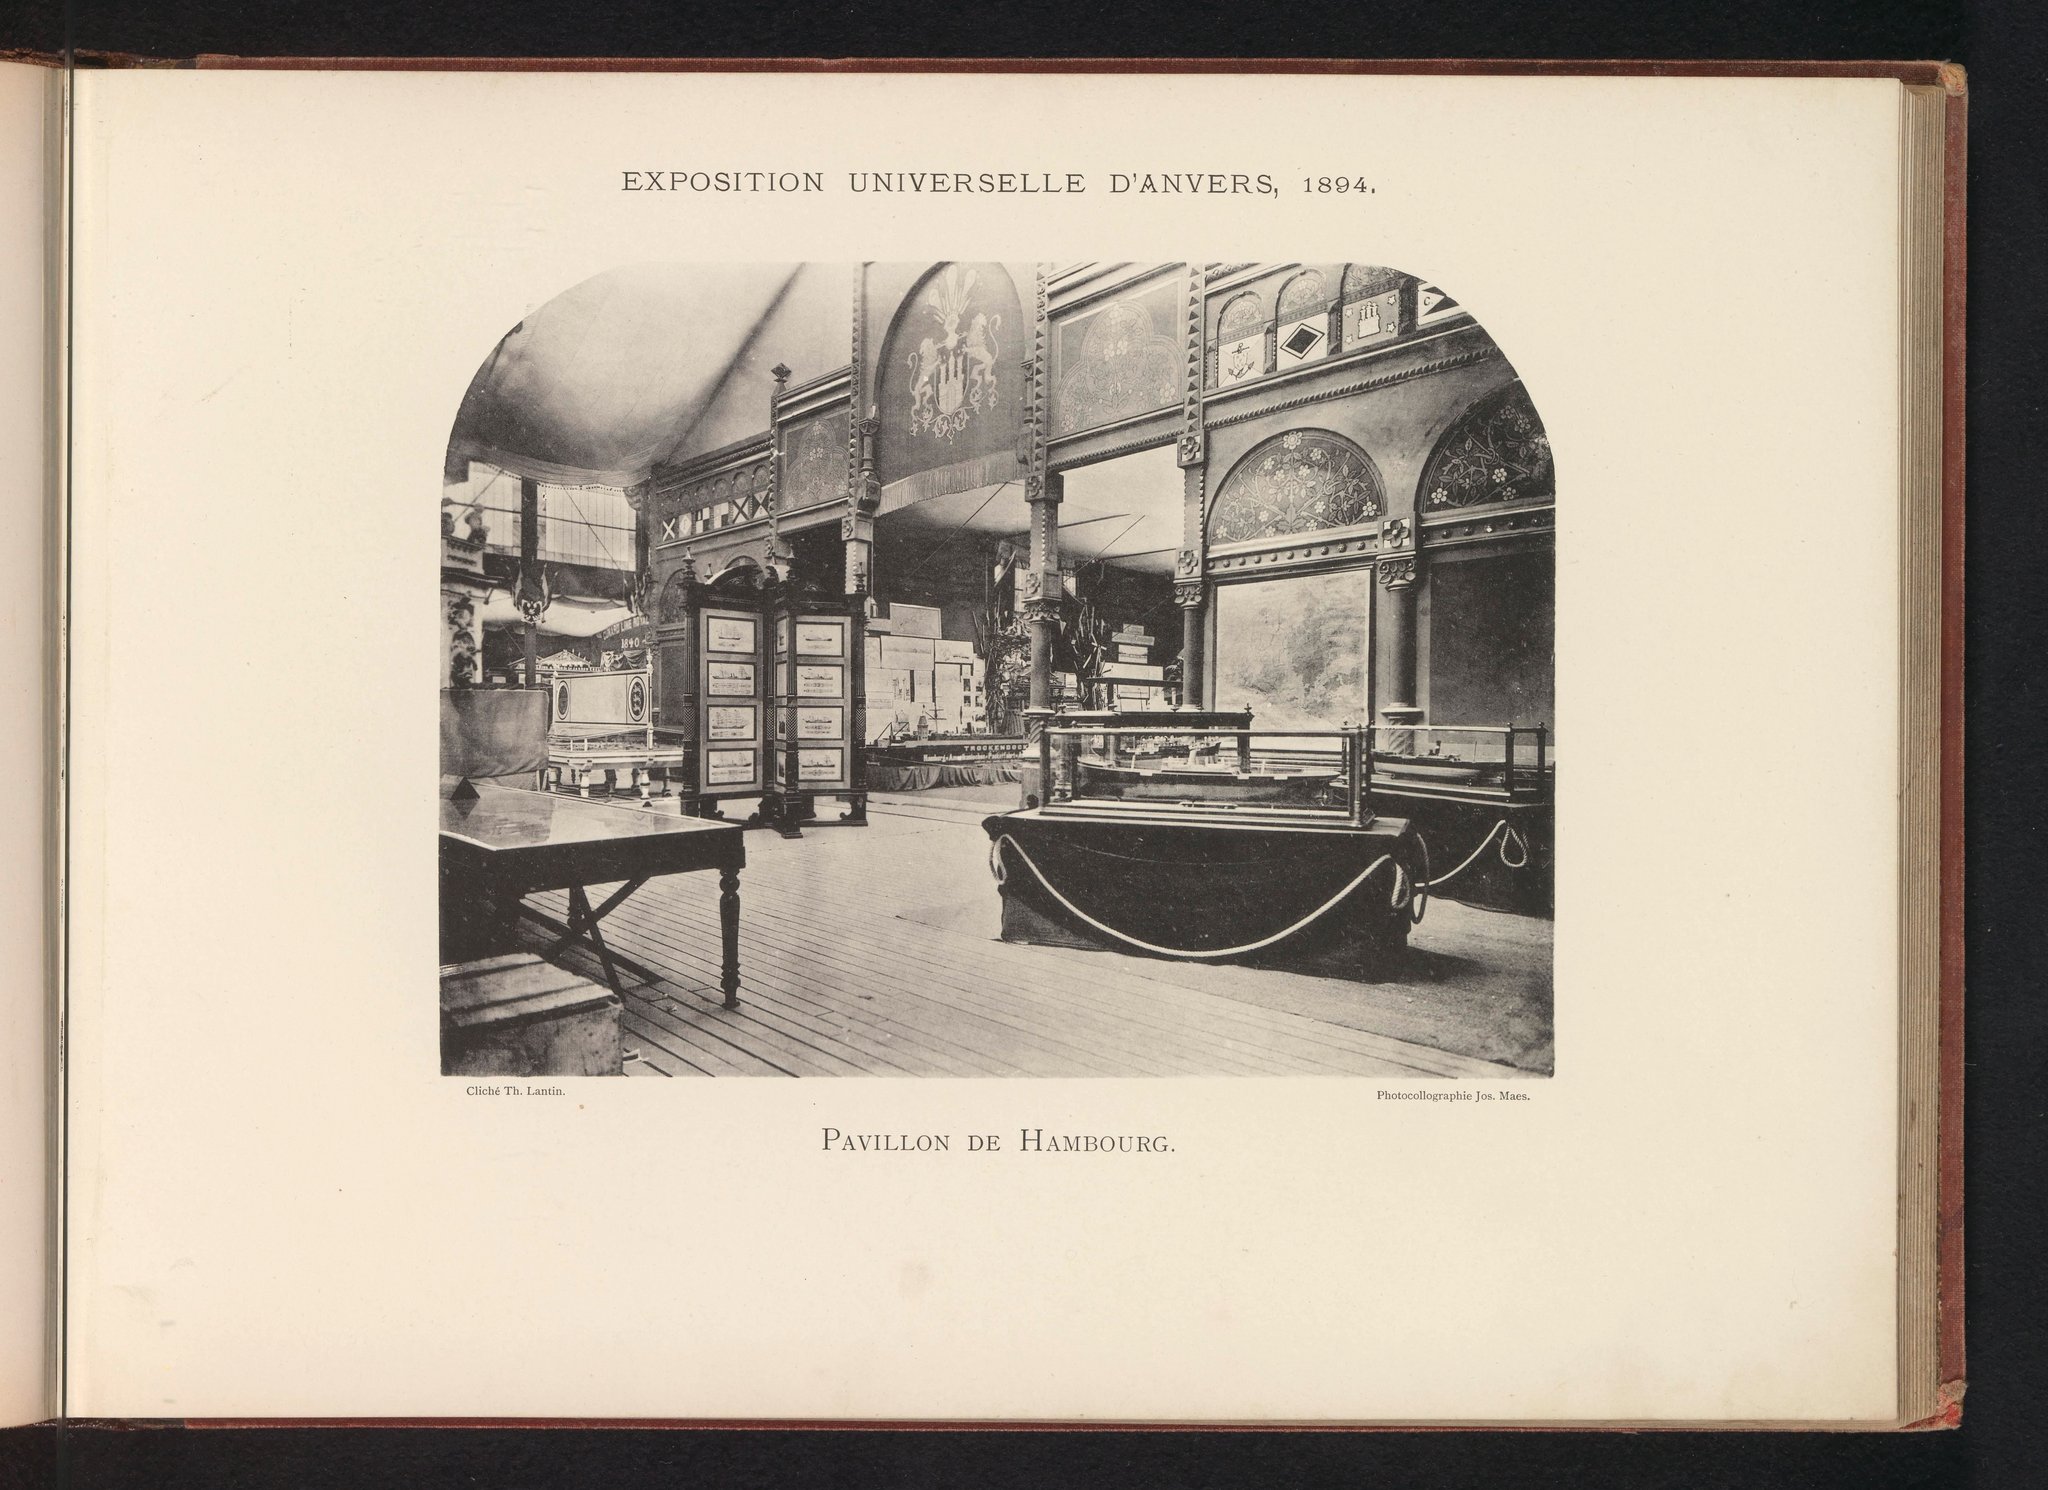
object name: page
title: Interieur van het paviljoen uit Hamburg tijdens de wereldtentoonstelling te Antwerpen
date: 1894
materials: paper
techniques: photograph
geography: antwerp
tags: world fair, world exhibition, interior ~ representation of a building, collection, exhibition, show